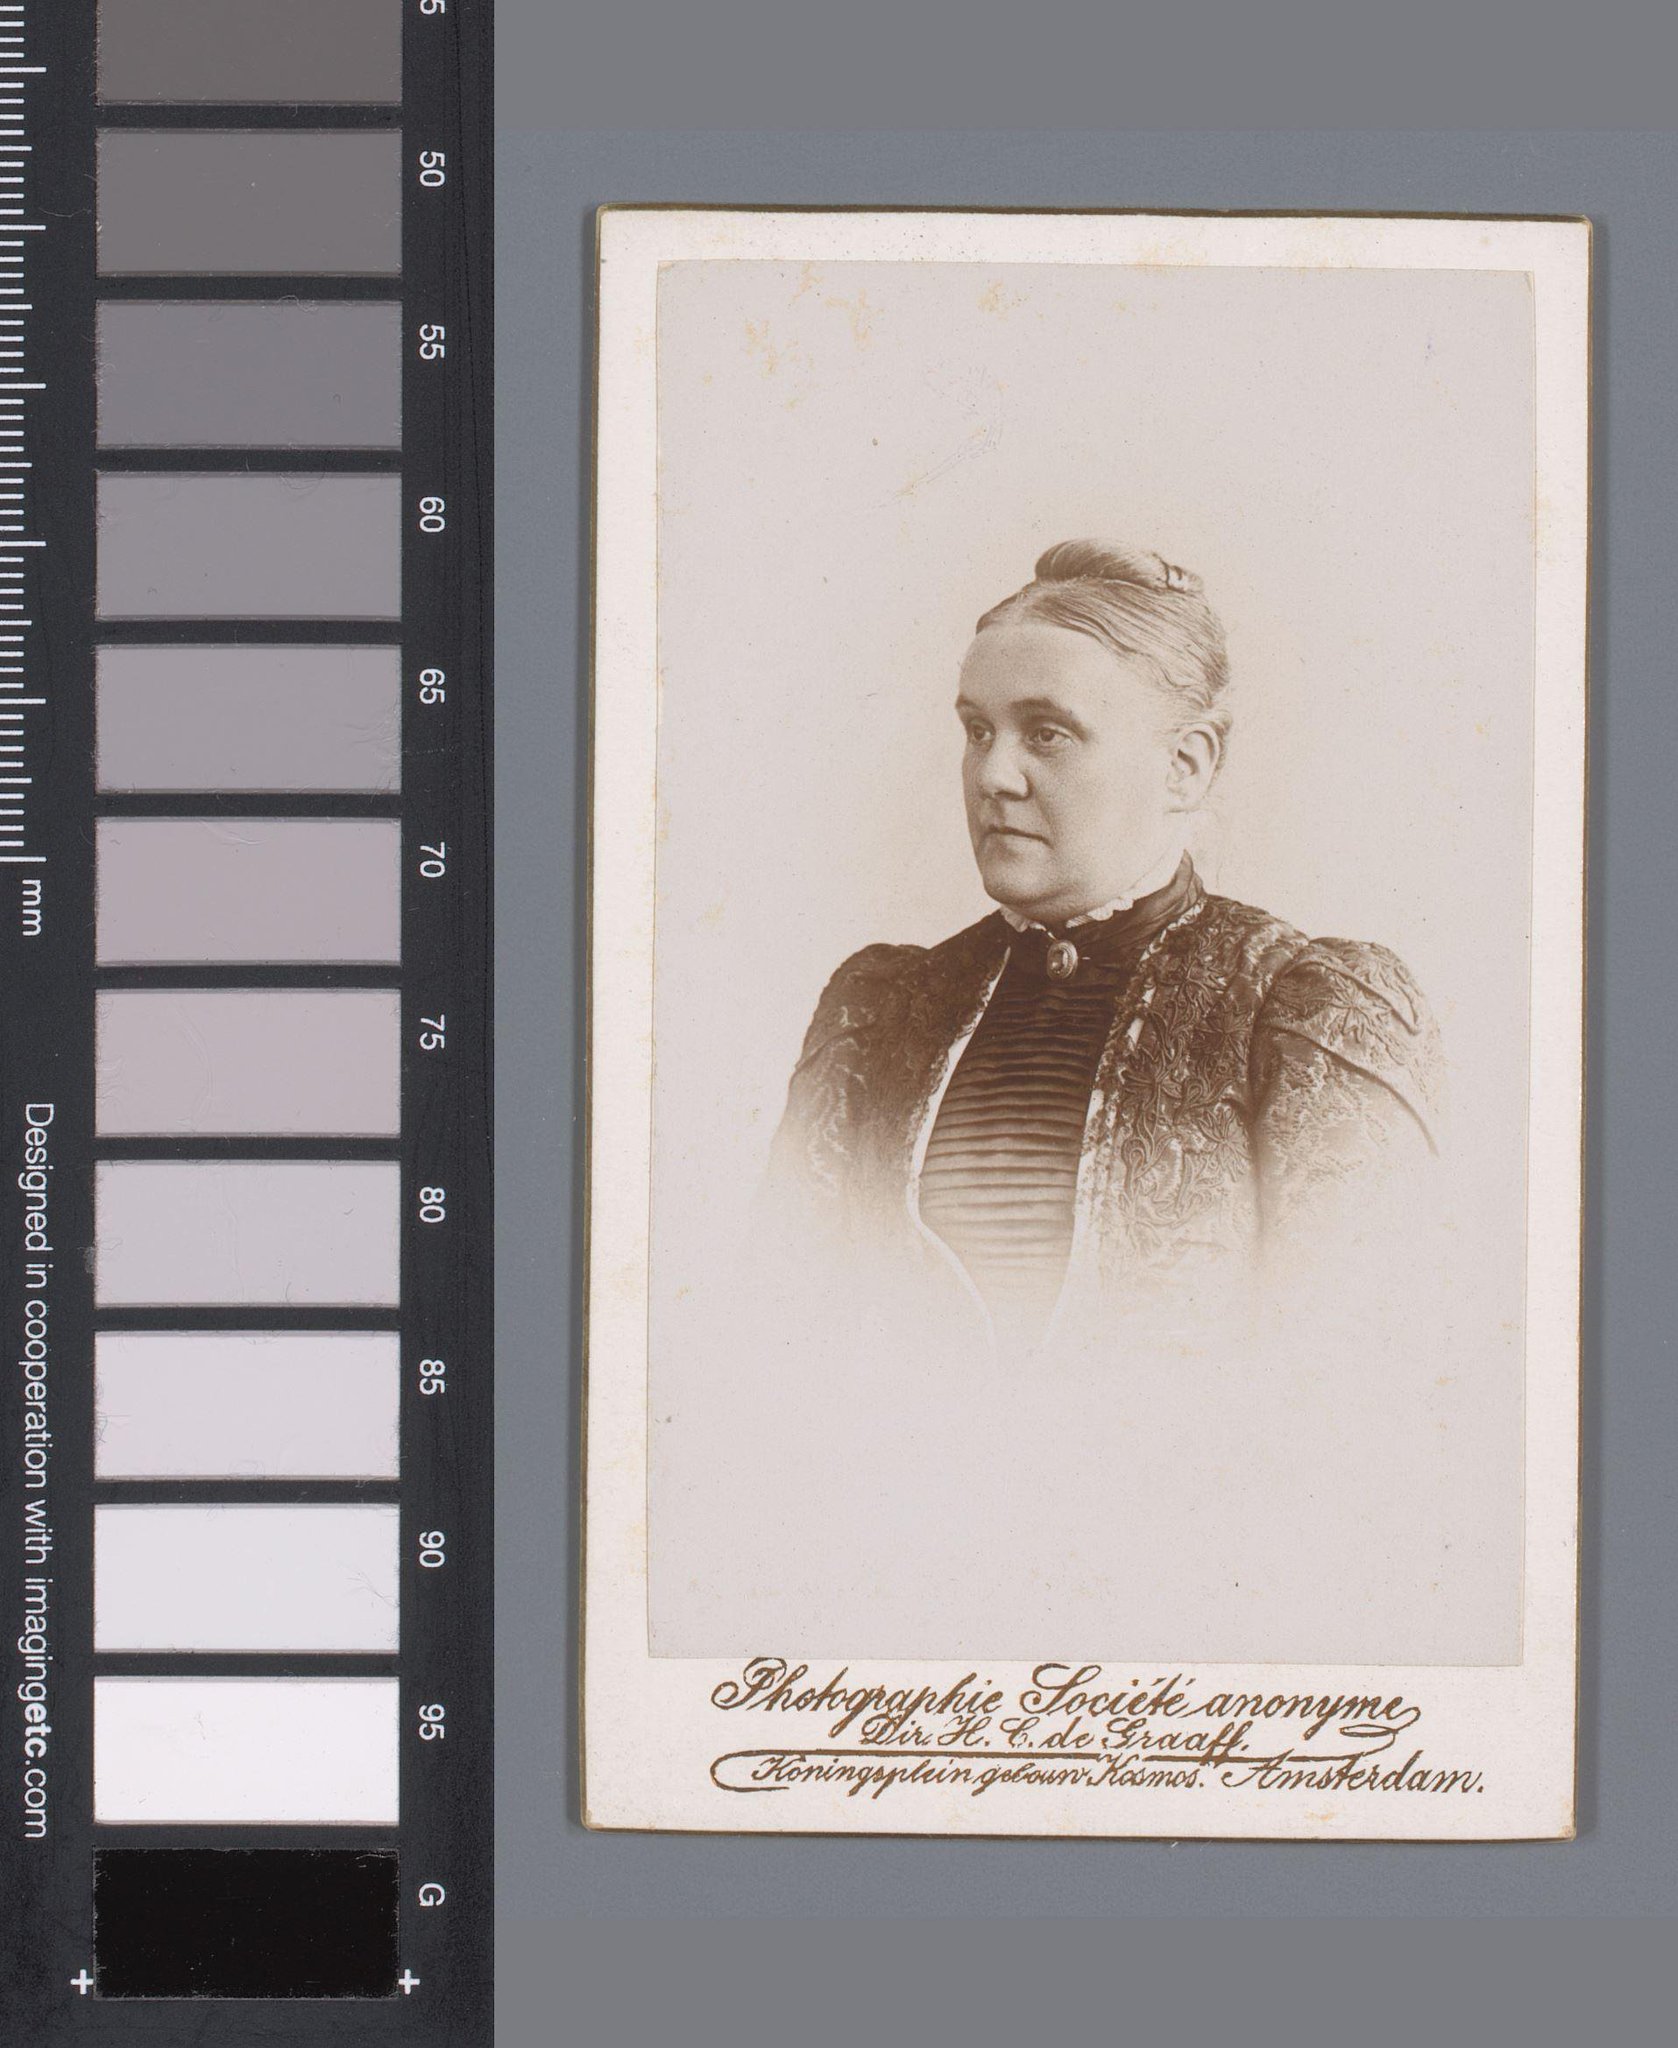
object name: photograph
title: Portret van een onbekende vrouw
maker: h.c. de graaff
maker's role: fotograaf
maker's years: 1853-1932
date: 1882-1922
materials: cardboard, photographic support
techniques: collodion silver print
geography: amsterdam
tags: historical persons - bb - woman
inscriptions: inscription: ‘Photographie Société anonyme/ Dir. H. C. de Graaf/ Koningsplein gebouw "Kosmos"/ AMSTERDAM./ Het Negatif blijft voor nabestellingen bewaard.’, inscription: ‘[...]/ Amsterdam’